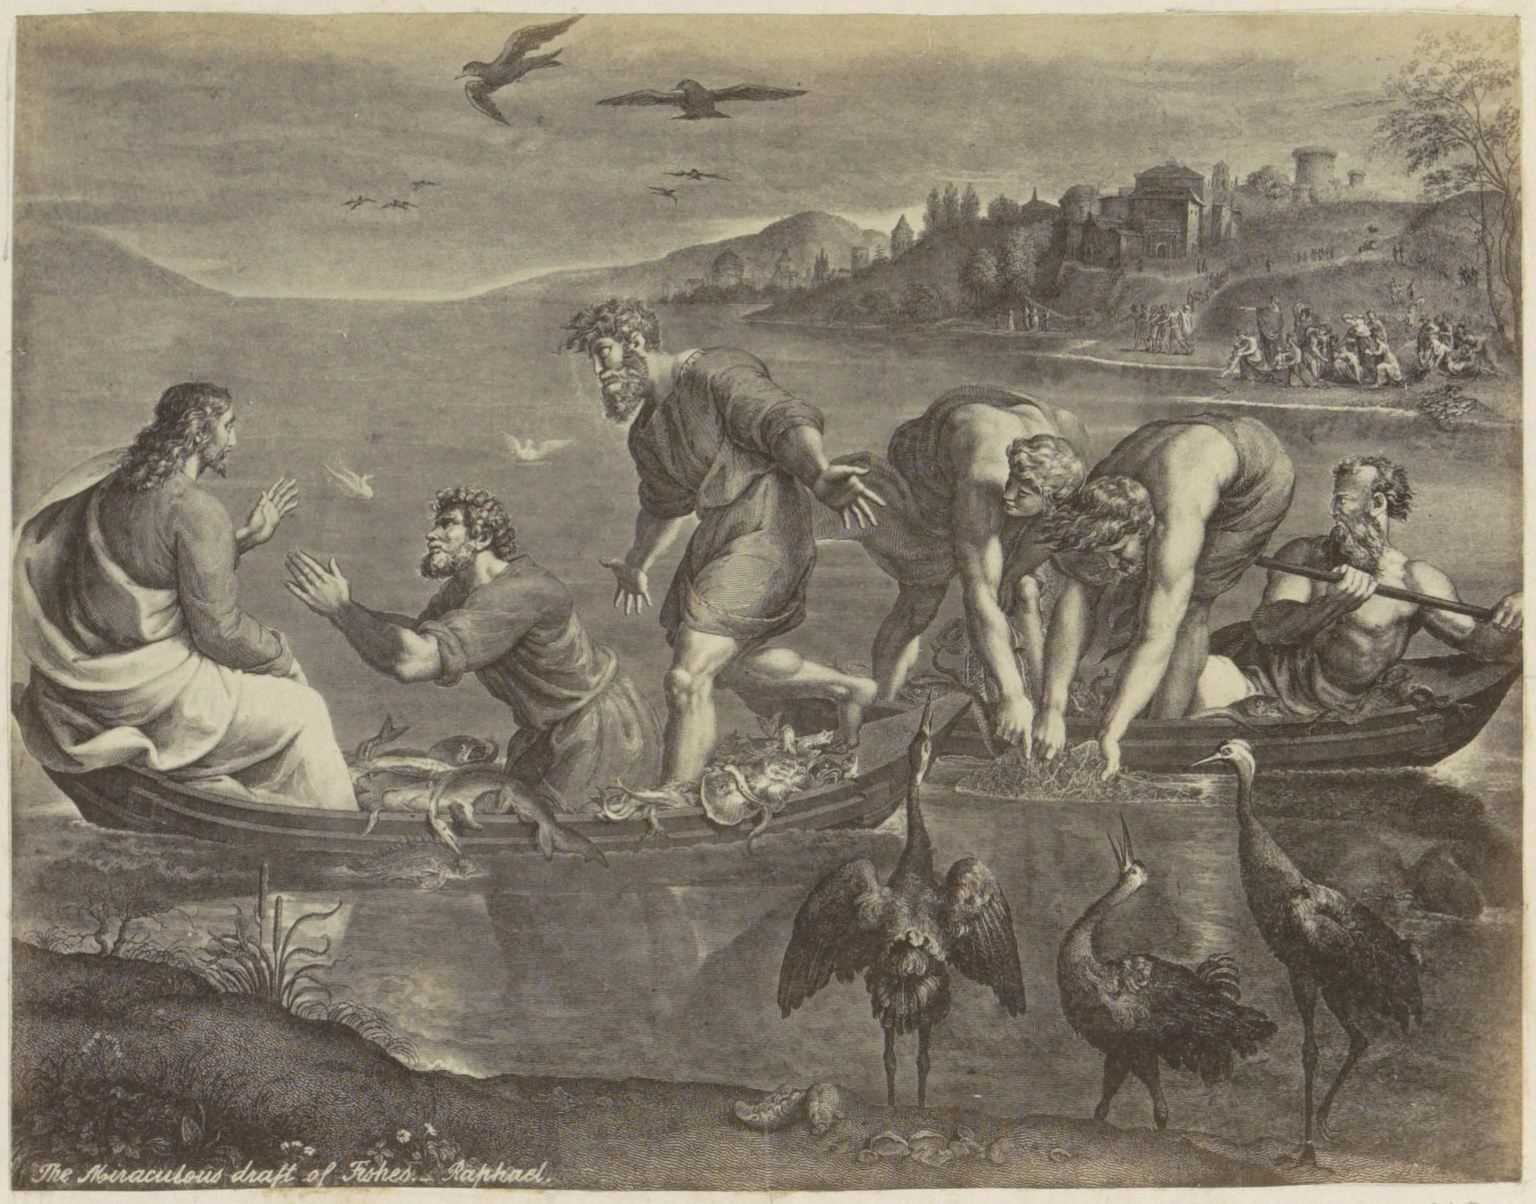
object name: reproduction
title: The Miraculous draft of Fishes. Raphael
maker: Anonymous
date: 1850-1870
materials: paper, photographic support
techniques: albumen print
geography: england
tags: the miraculous draught of fishes (before the resurrection) on the lake of gennesaret (sea of galilee); james and john helping to bring in the nets (luke 5:1-11)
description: Onderdeel van Album met foto's van bezienswaardigheden en landschappen in Engeland en van kunst.